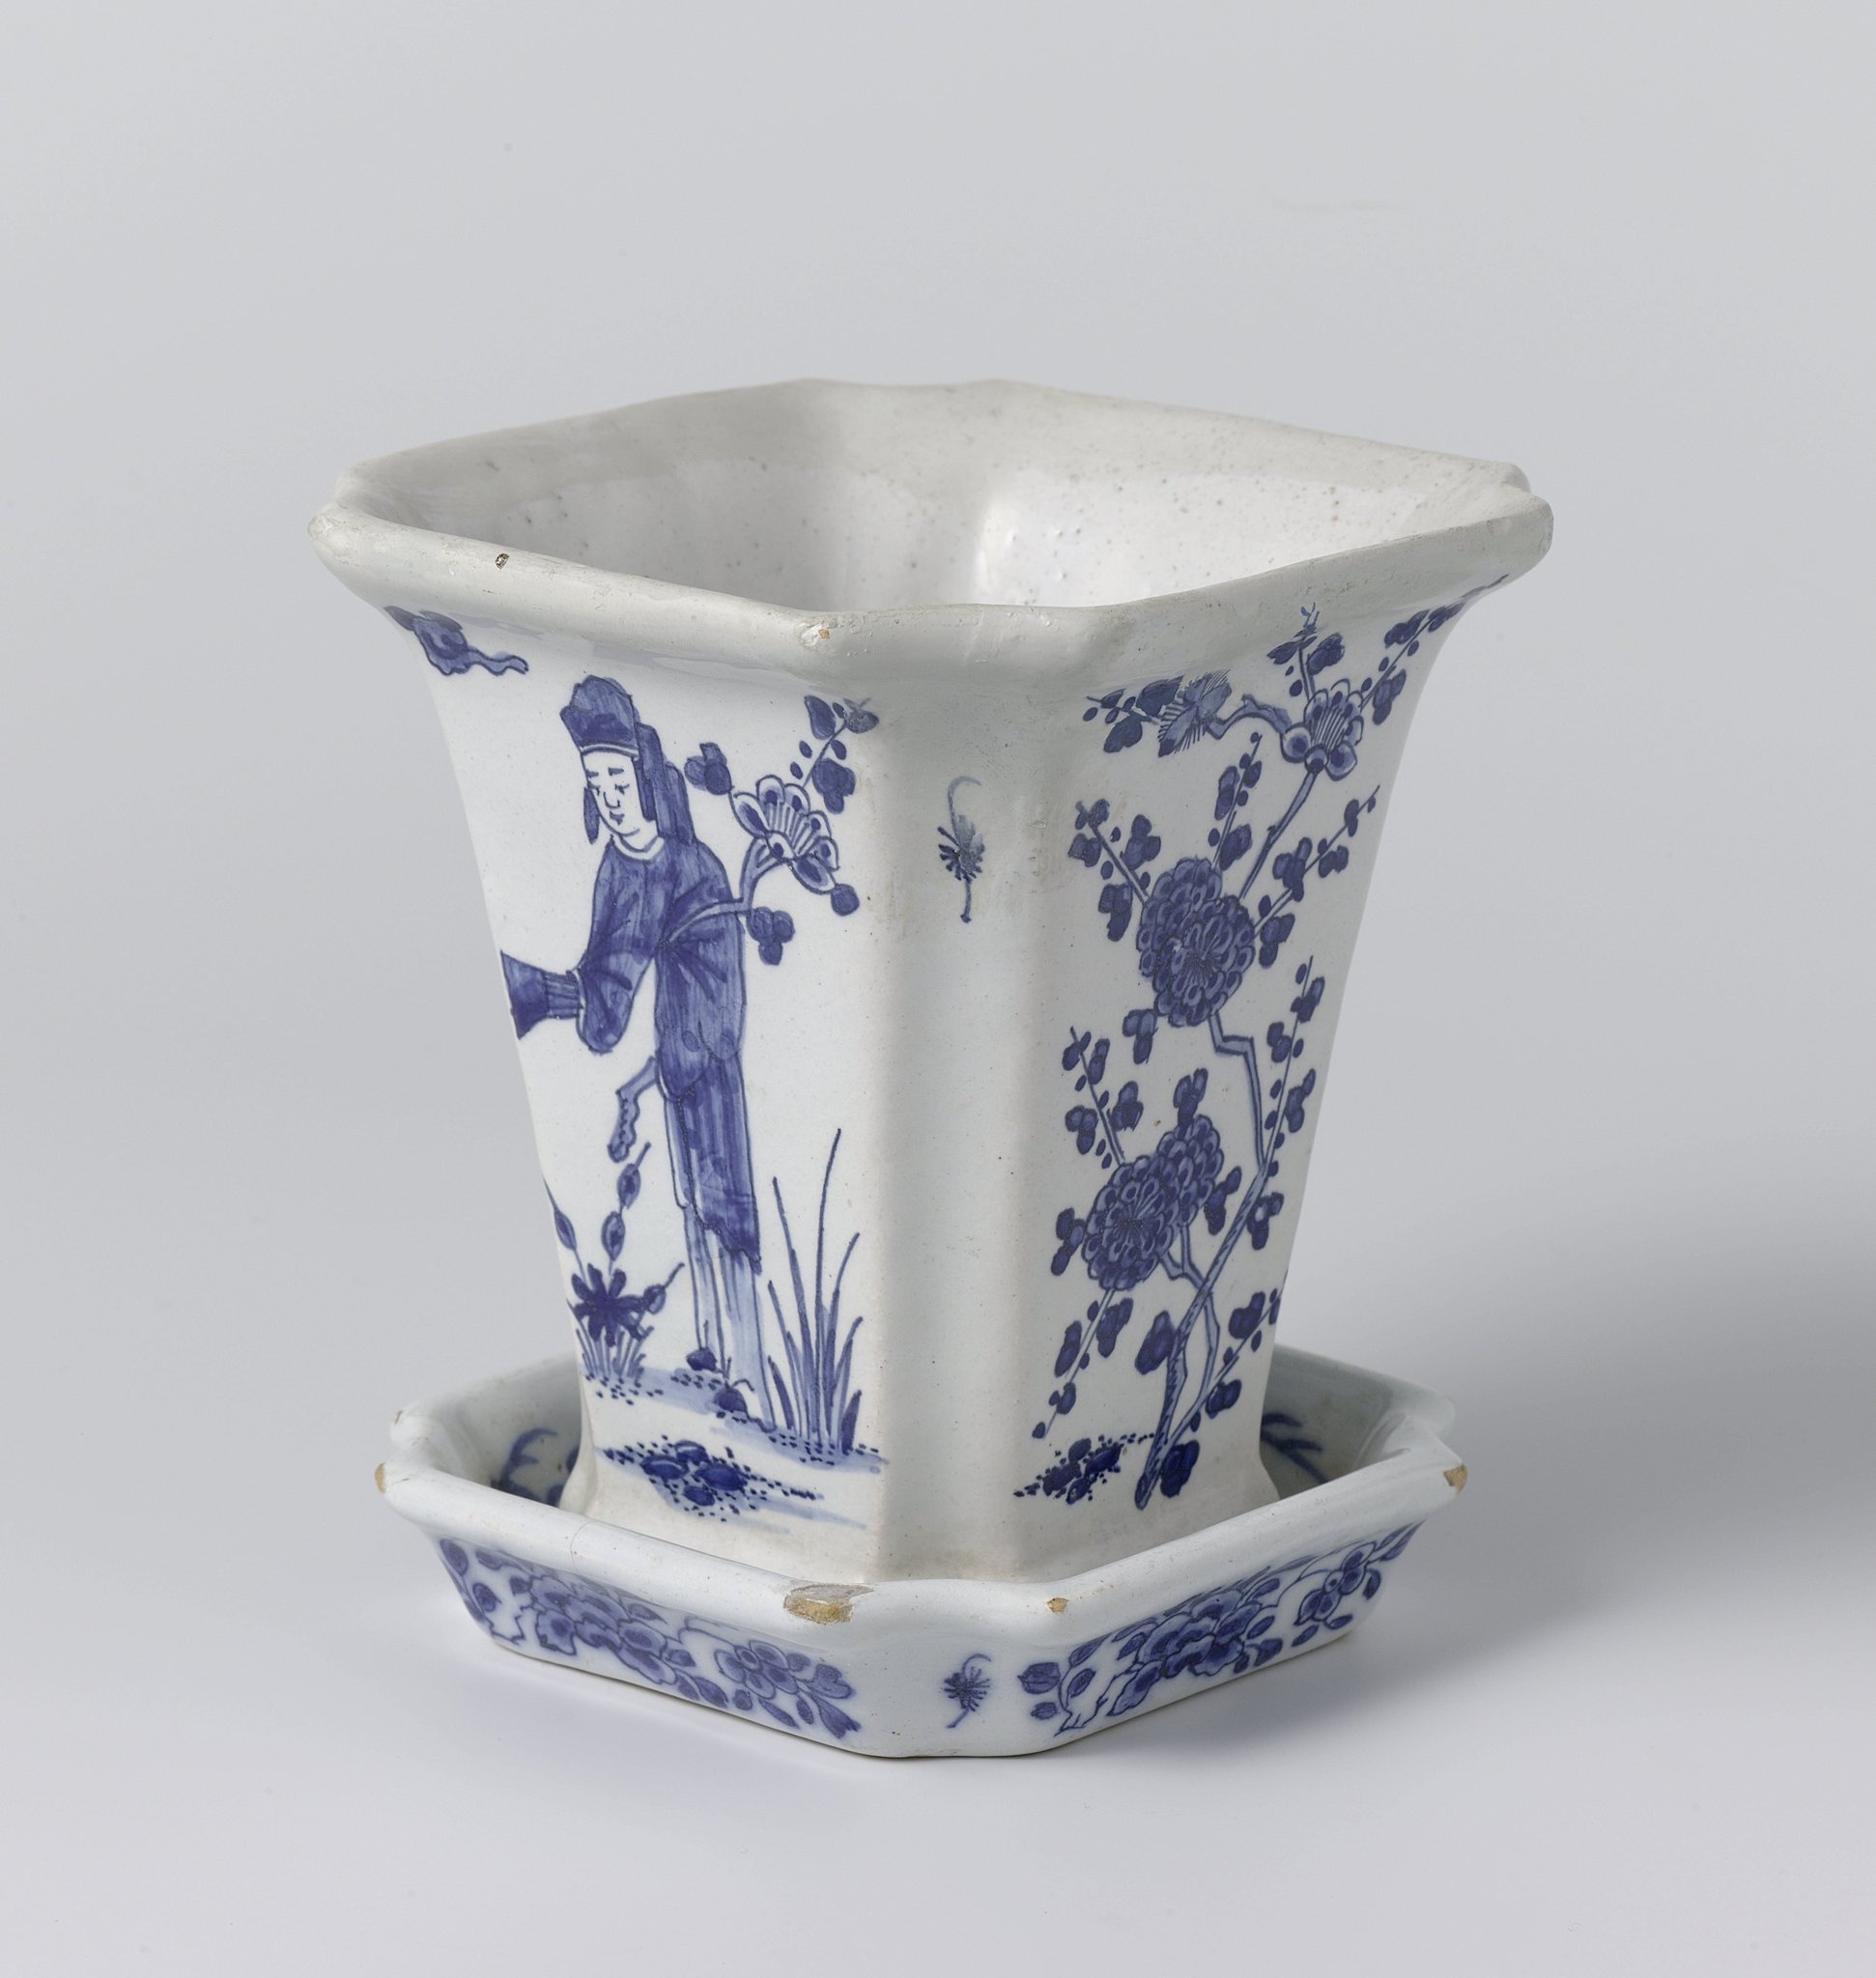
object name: platter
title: Onderschotel voor een bloempot van faience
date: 1740-1775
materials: faience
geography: delft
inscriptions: mark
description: Onderschotel van faience. Blauw beschilderd met bloemtakken.